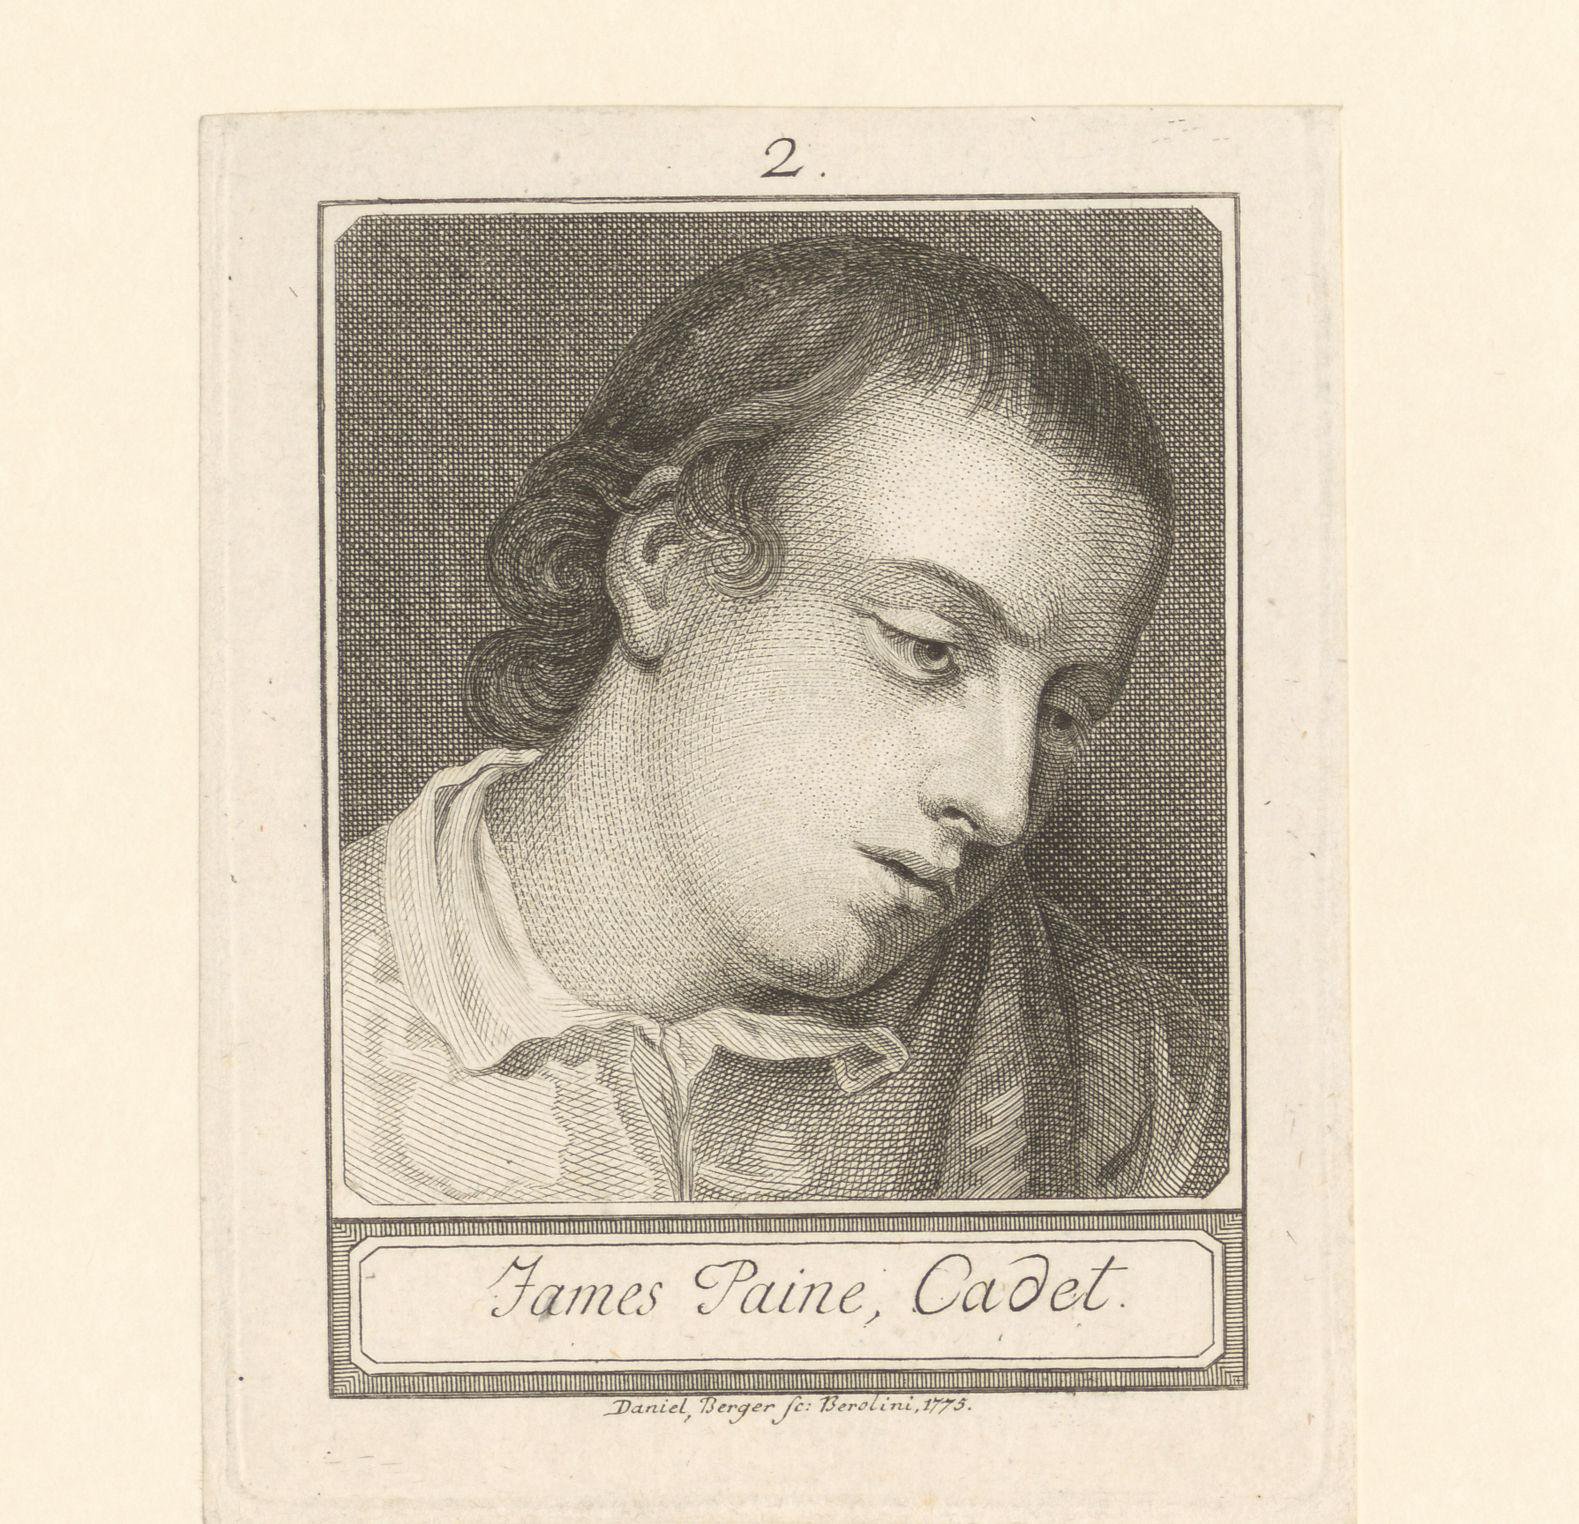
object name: print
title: Portret van James Paine II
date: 1775-1824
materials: paper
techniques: etching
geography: berlin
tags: historical persons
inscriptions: collector's mark: Lugt 2228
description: Prent waarschijnlijk gebruikt als boekillustratie.